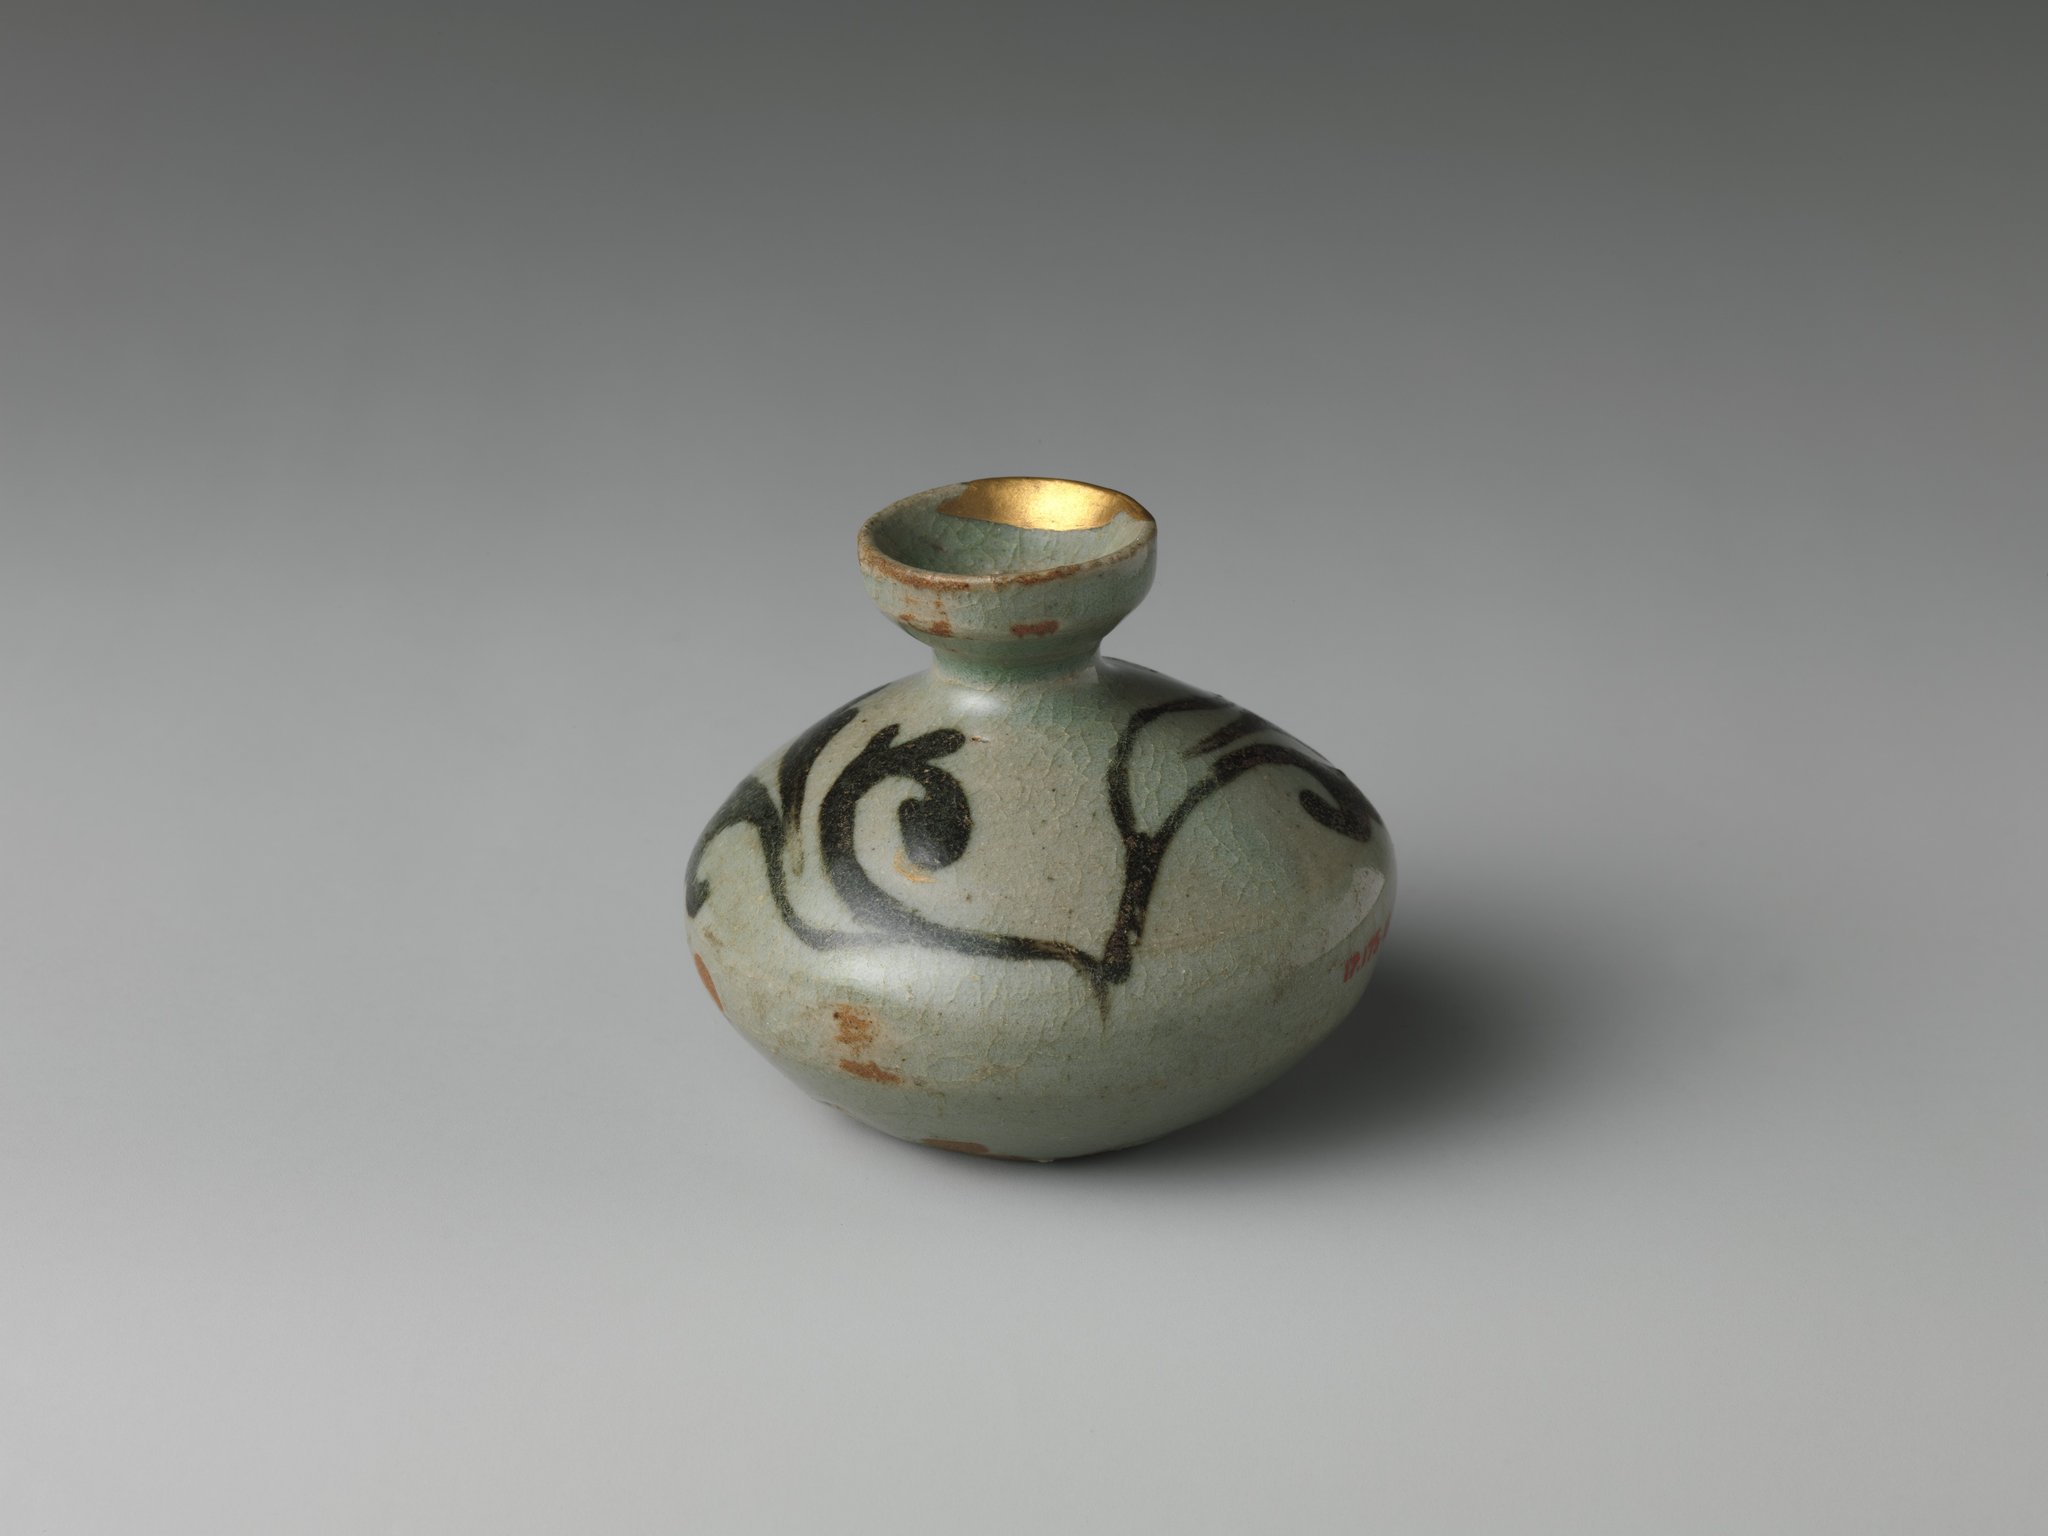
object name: oil bottle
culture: korean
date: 1101-1200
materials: ceramic glaze, glaze, iron, stoneware